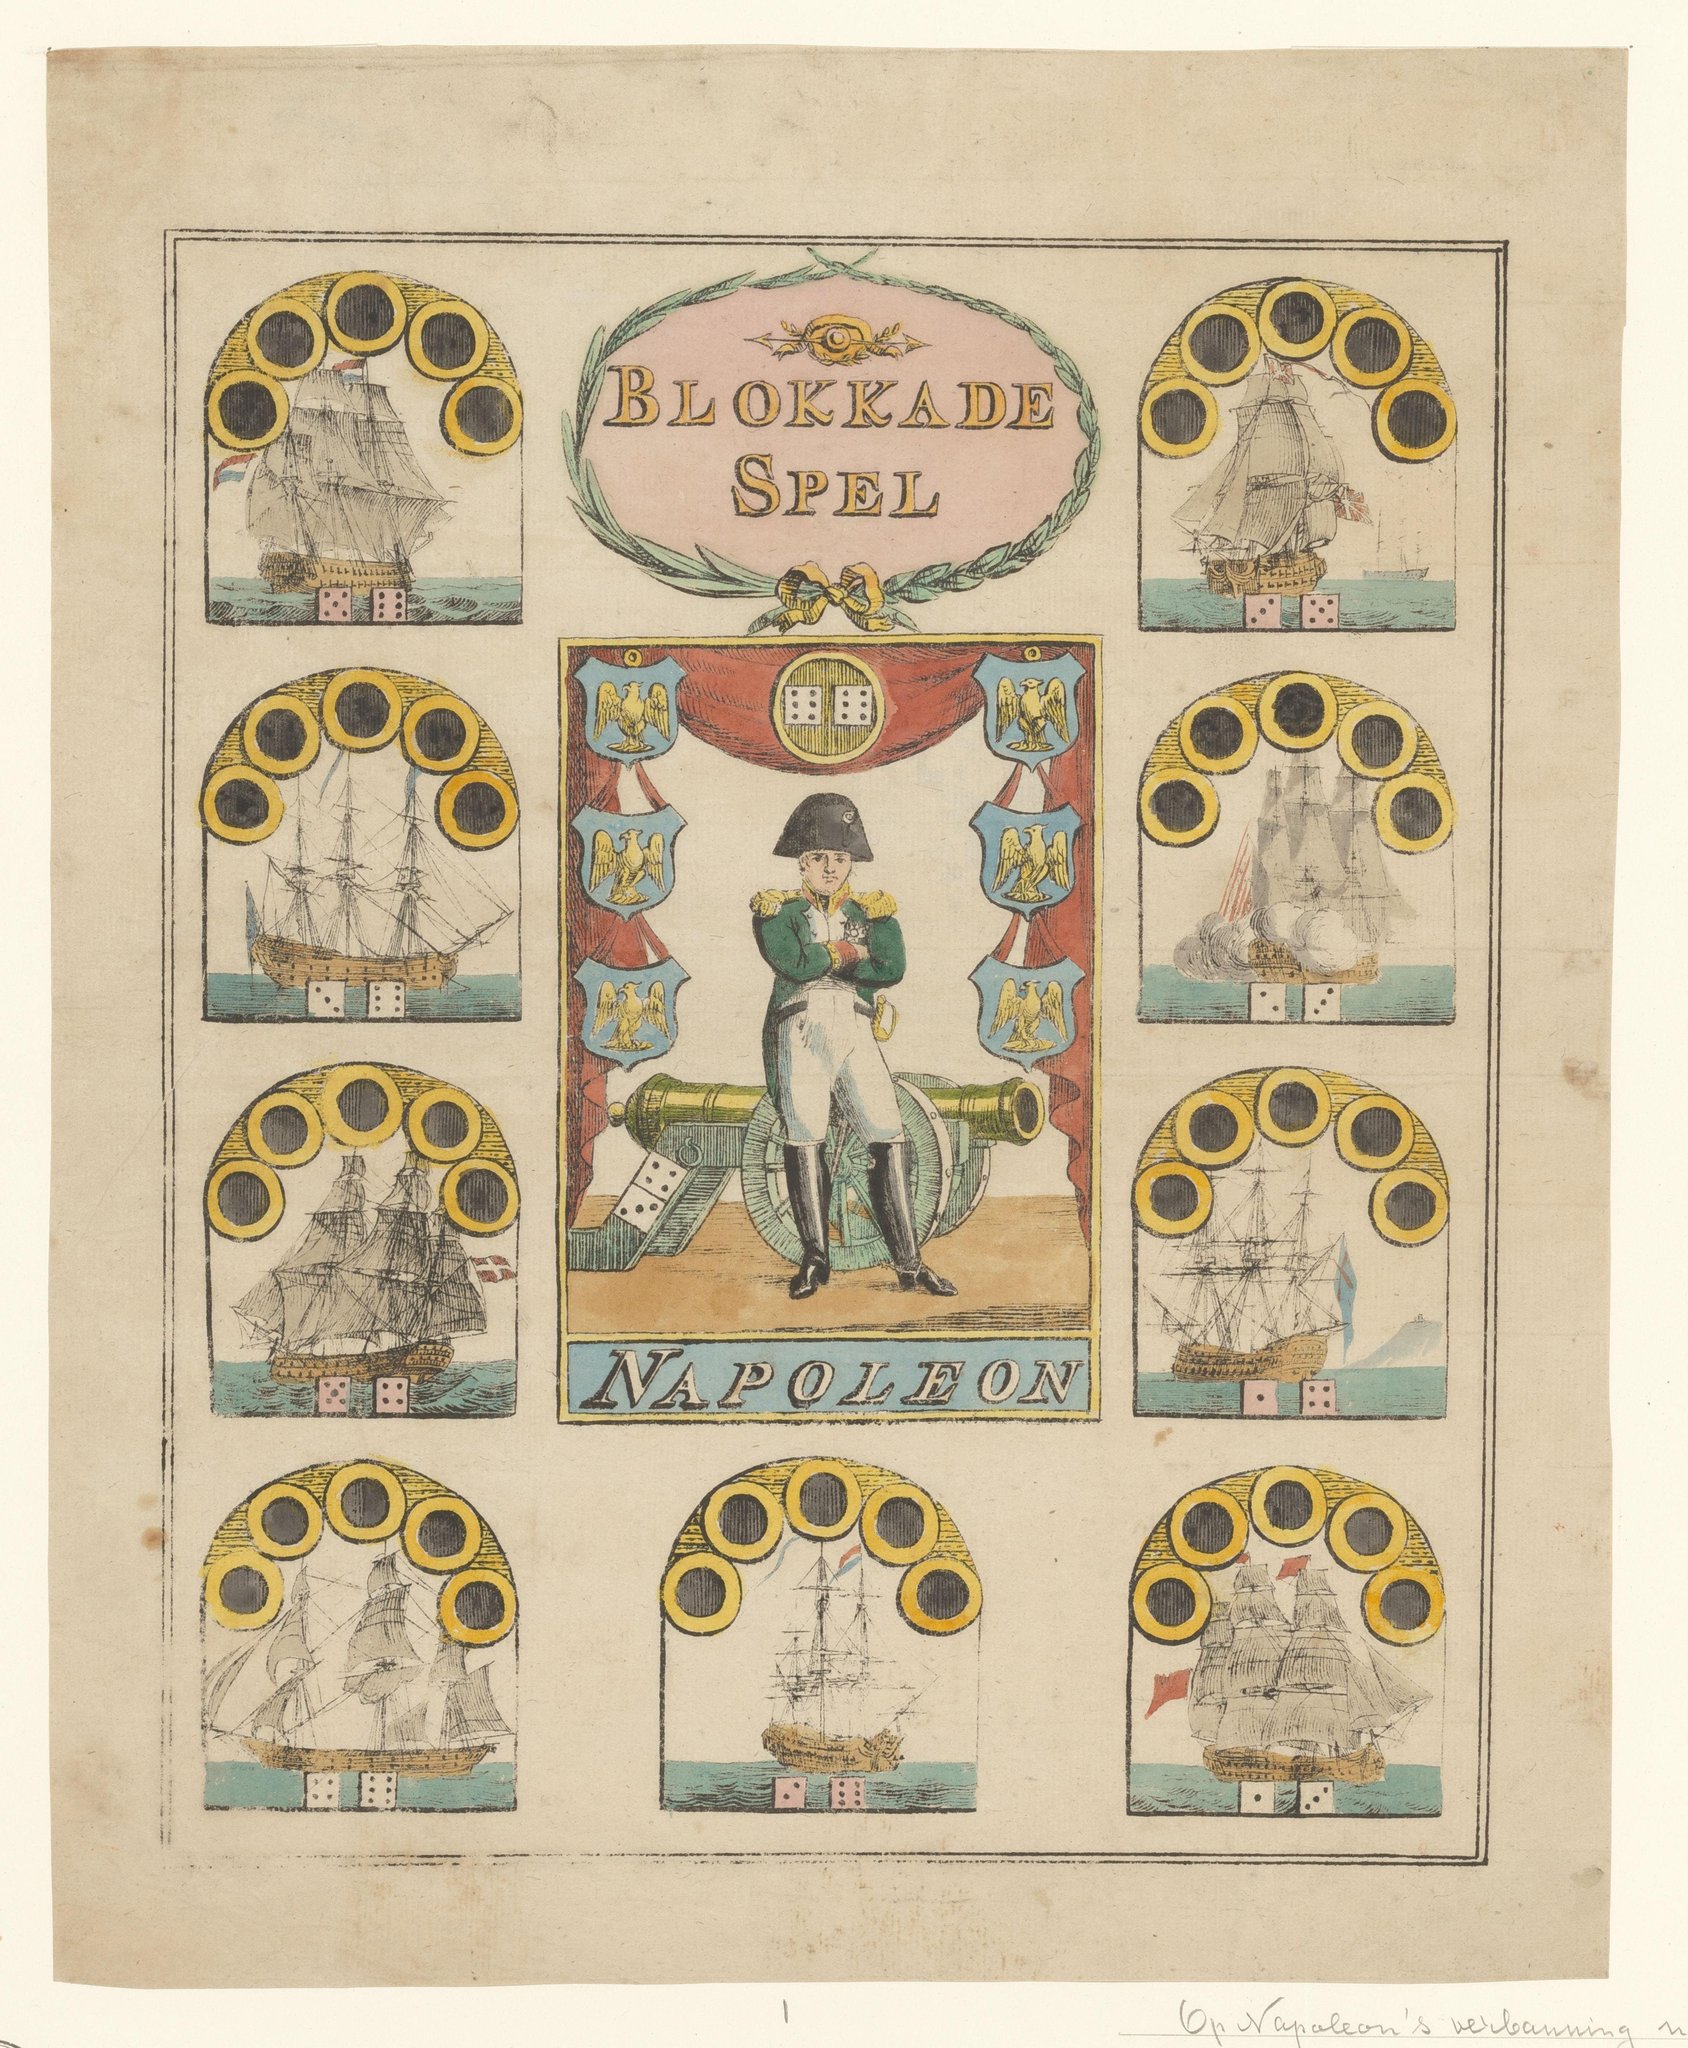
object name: gameboard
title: Blokkade Spel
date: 1814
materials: paper, watercolor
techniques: hand coloring, lithograph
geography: amsterdam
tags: napoleon i (emperor of the french), sailing-ship, sailing-boat, board-games of chance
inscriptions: collector's mark, collector's mark: Lugt 1641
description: Bordspel gebaseerd op Napoleons verbanning naar Elba, mei 1814. In het midden Napoleon staande voor een kanon. Hieromheen negen vakken waarin de oorlogsschepen van de bondgenoten die de blokkade om het eiland Elba vormen. Bij de prent behoort een afzonderlijk blad met de spelregels. Onderwerpsrubrieken binnen de Atlas Zeden en Gewoonten: Spel en Vermaak; gezelschapsspel, ganzenbord en dergelijke.